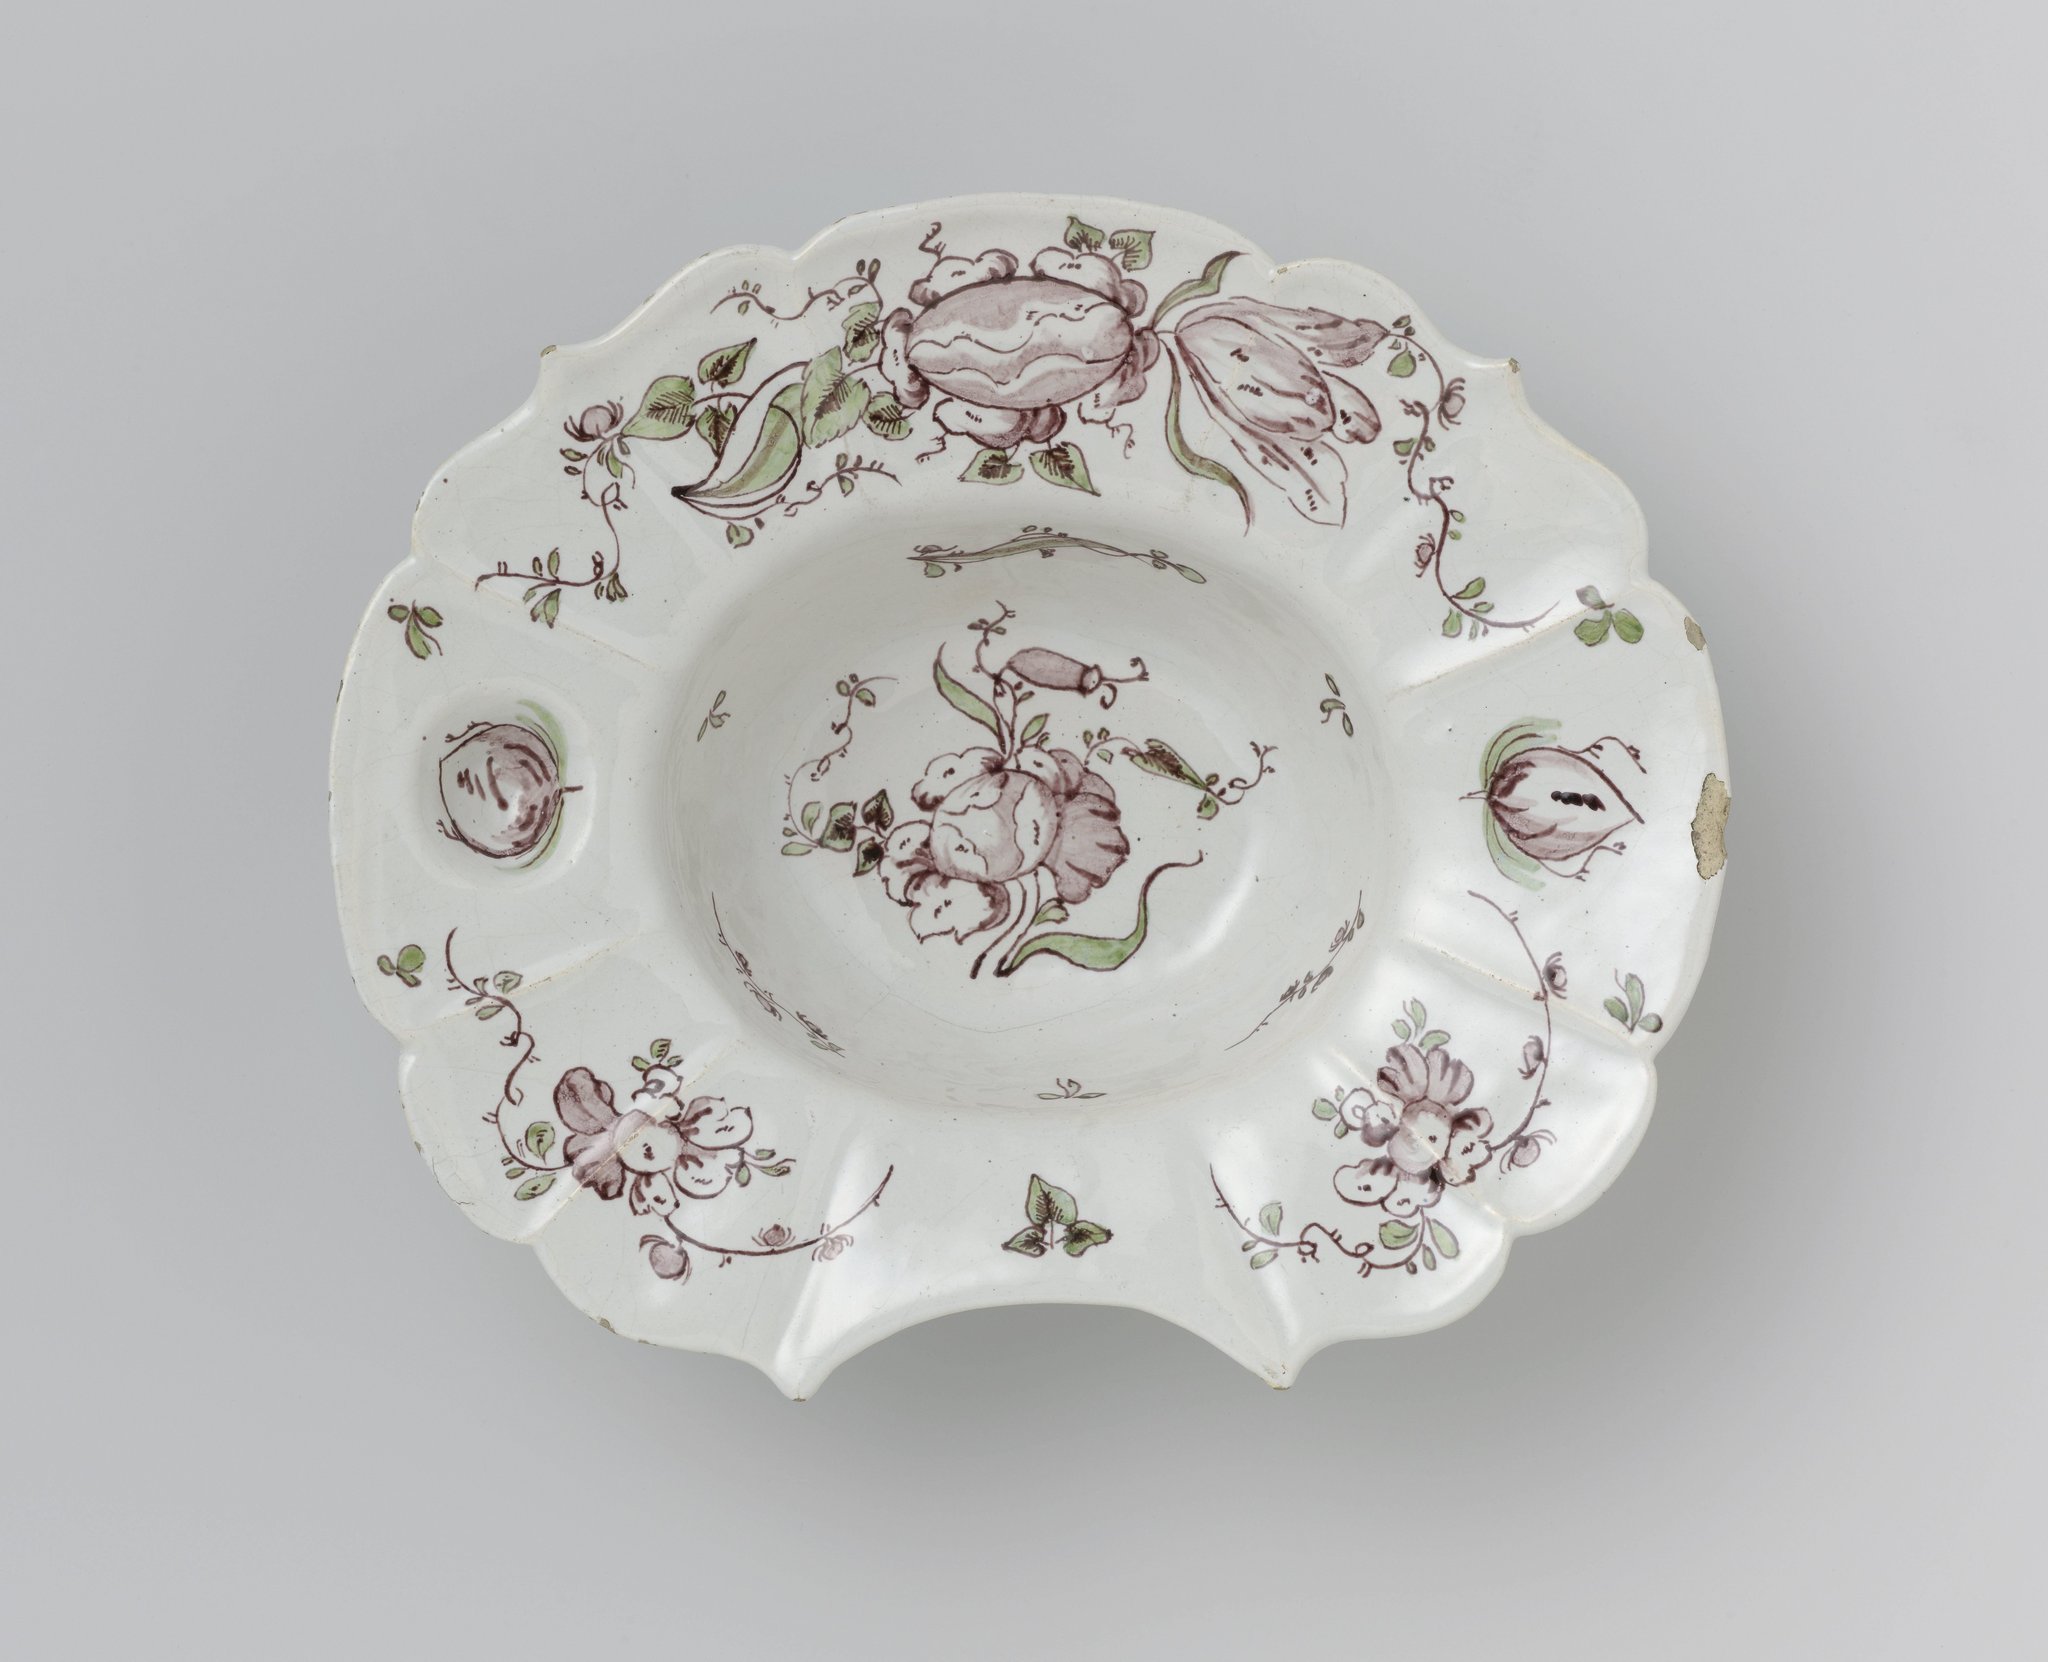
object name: shaving basin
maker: arent klos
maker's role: plateelbakker, plateelschilder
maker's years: 1732-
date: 1775-1790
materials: earthenware, glaze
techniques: painted, polychromy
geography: schiedam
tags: flowers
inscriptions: mark: ‘A. Klos/ Sdam’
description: Scheerbekken van veelkleurig beschilderde faience in de kleuren groen en mangaan. Het scheerbekken is beschilderd met bloemen en bloemenranken en is gemerkt.